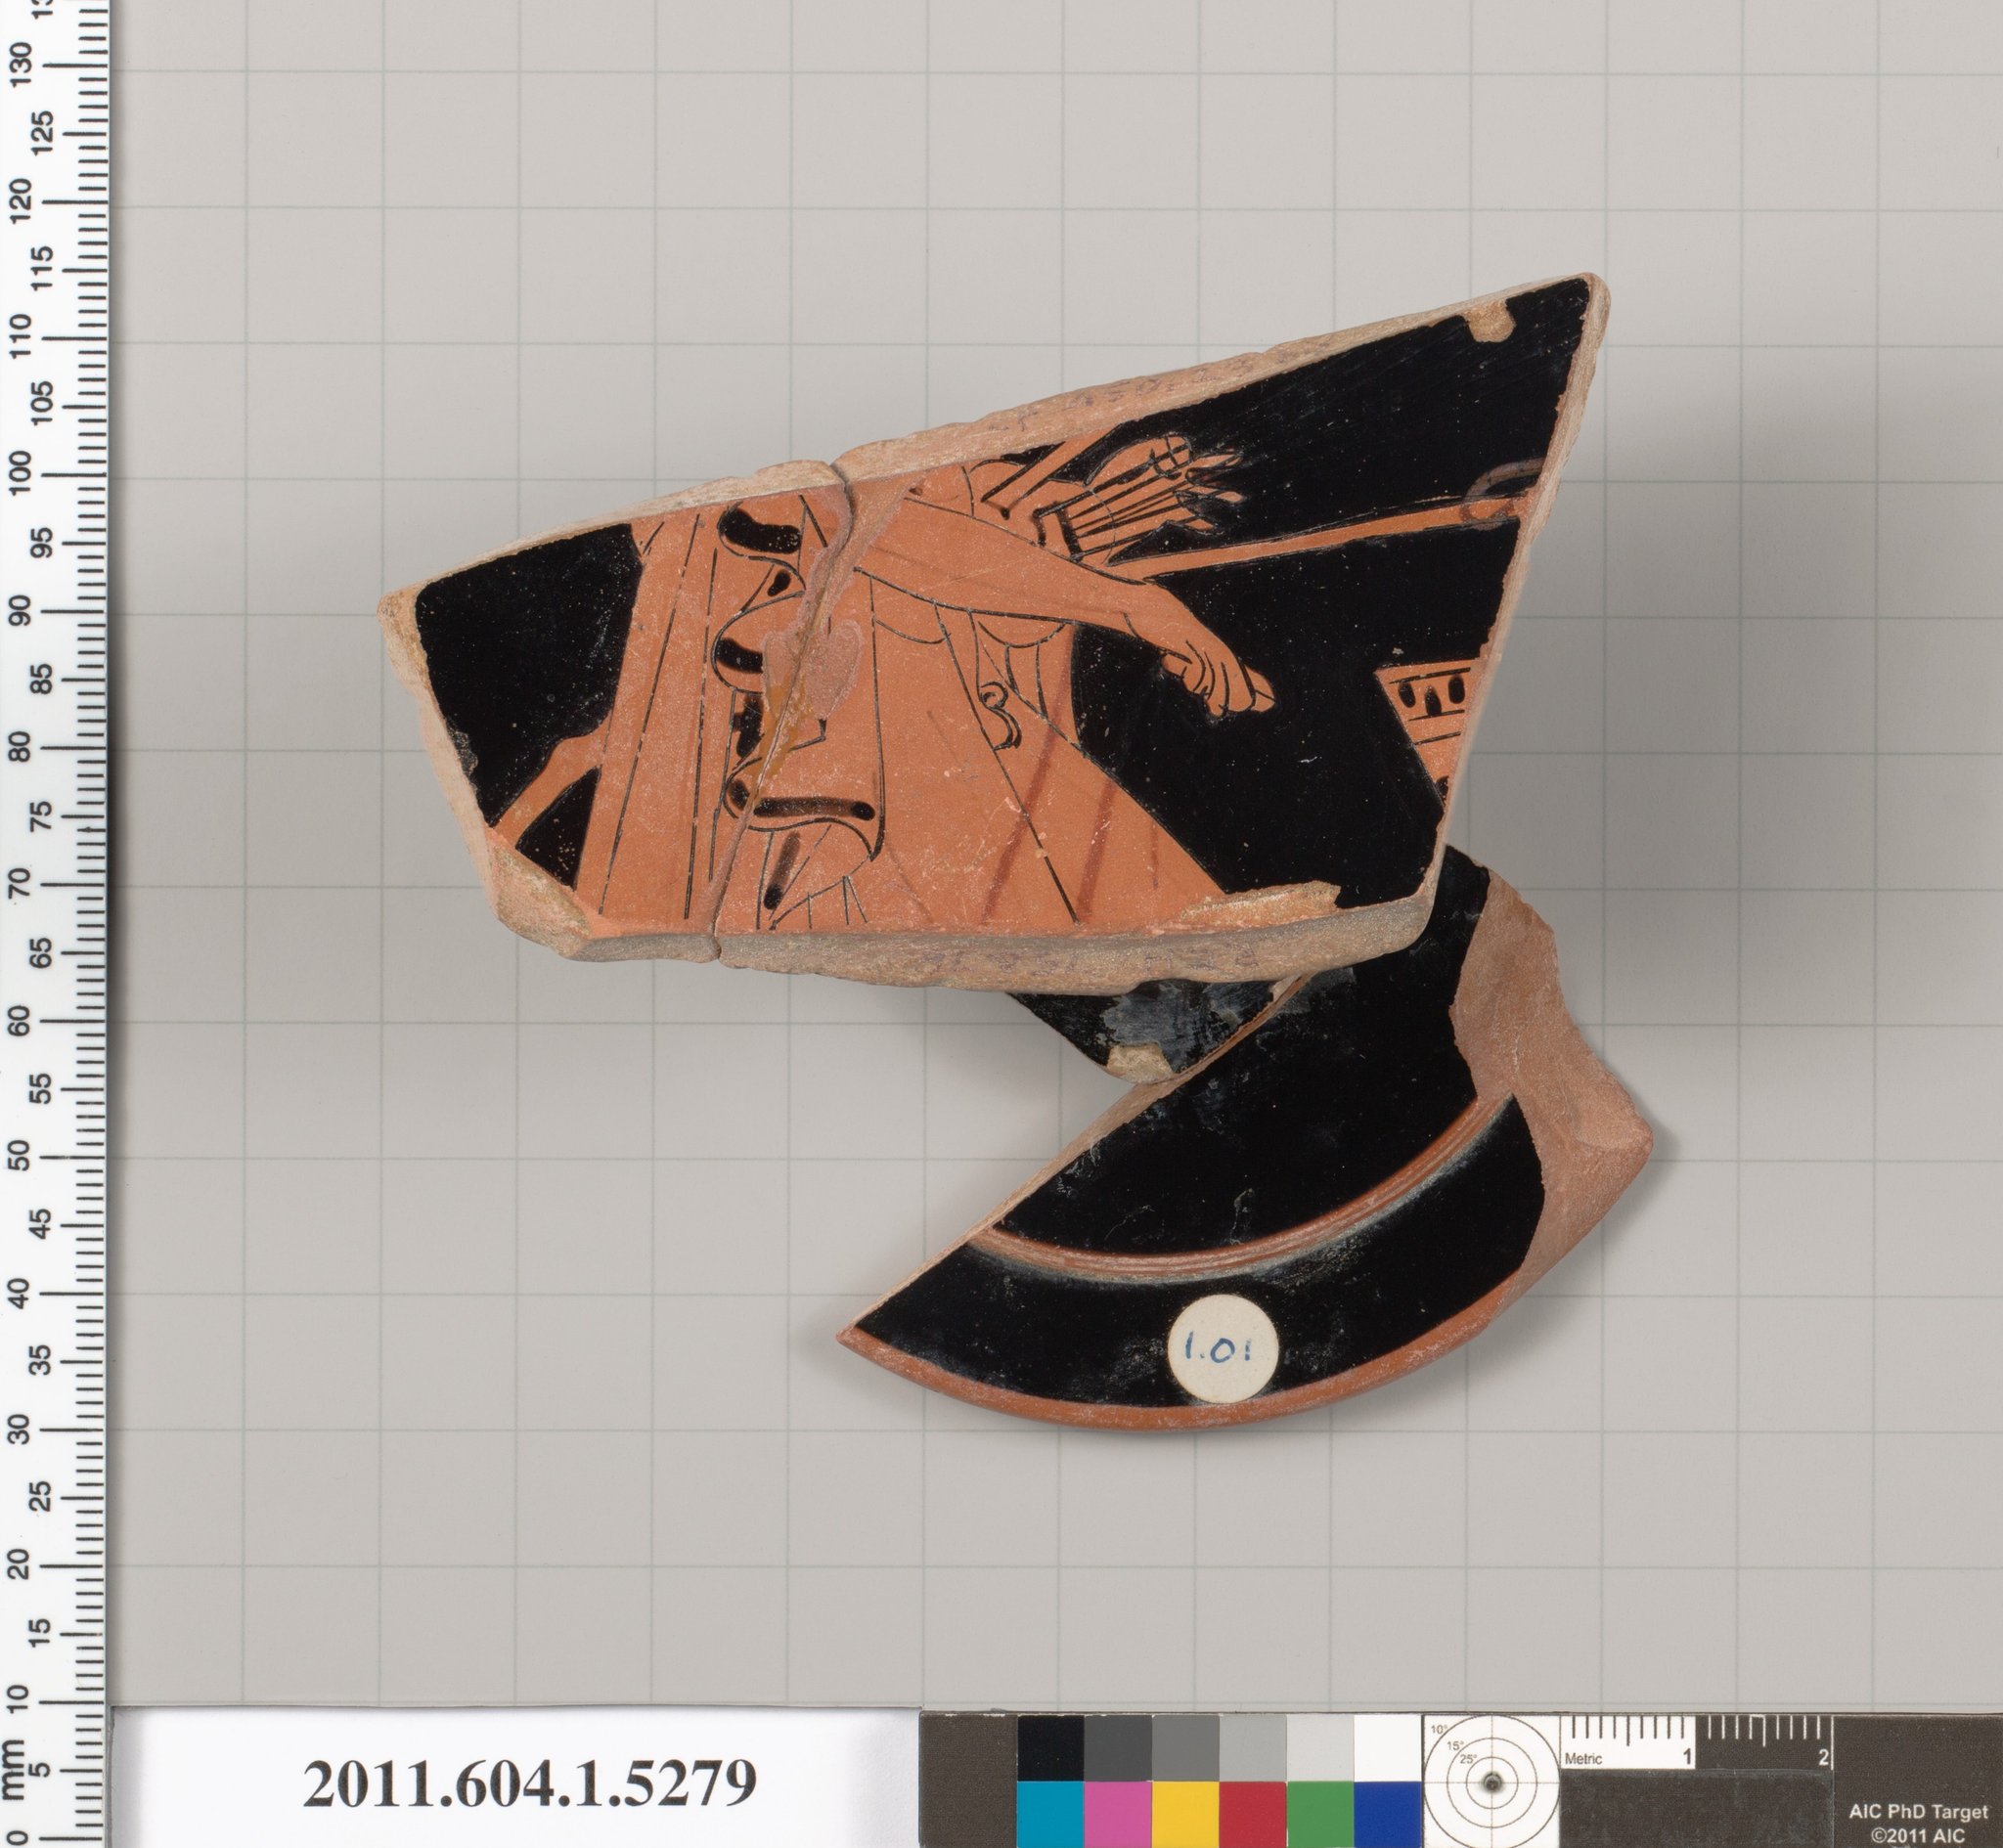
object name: kylix fragment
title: Terracotta fragment of a kylix (drinking cup)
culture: greek, attic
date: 490-470 BCE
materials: terracotta